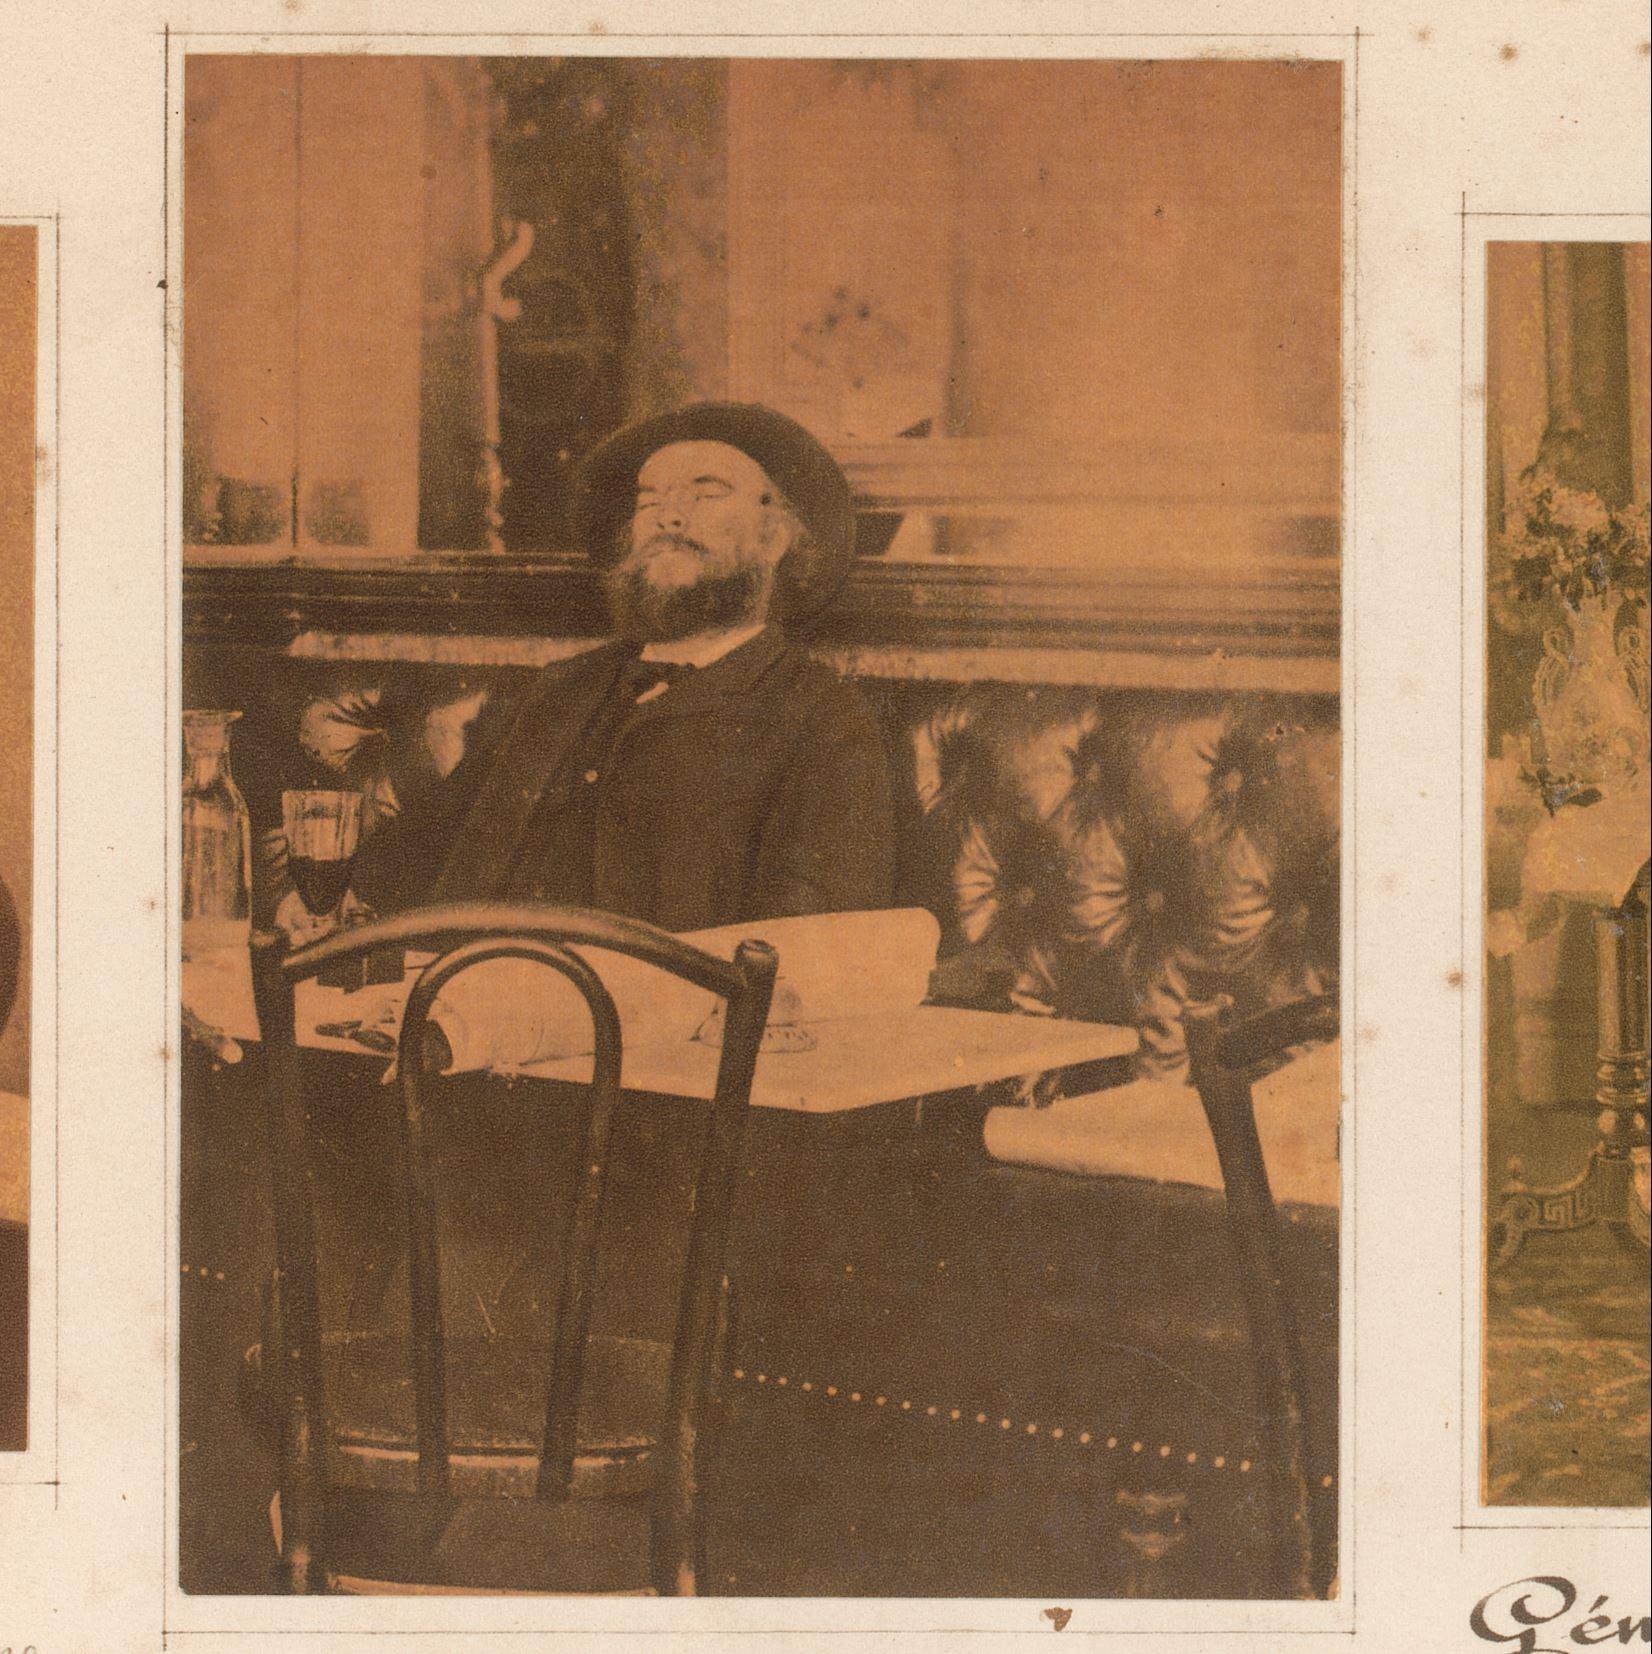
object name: album leaf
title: Portret van Paul Verlaine in een café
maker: Anonymous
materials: paper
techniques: rotogravure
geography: france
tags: paul verlaine, writer, poet, author, france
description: Deze prent maakt deel uit van een album.